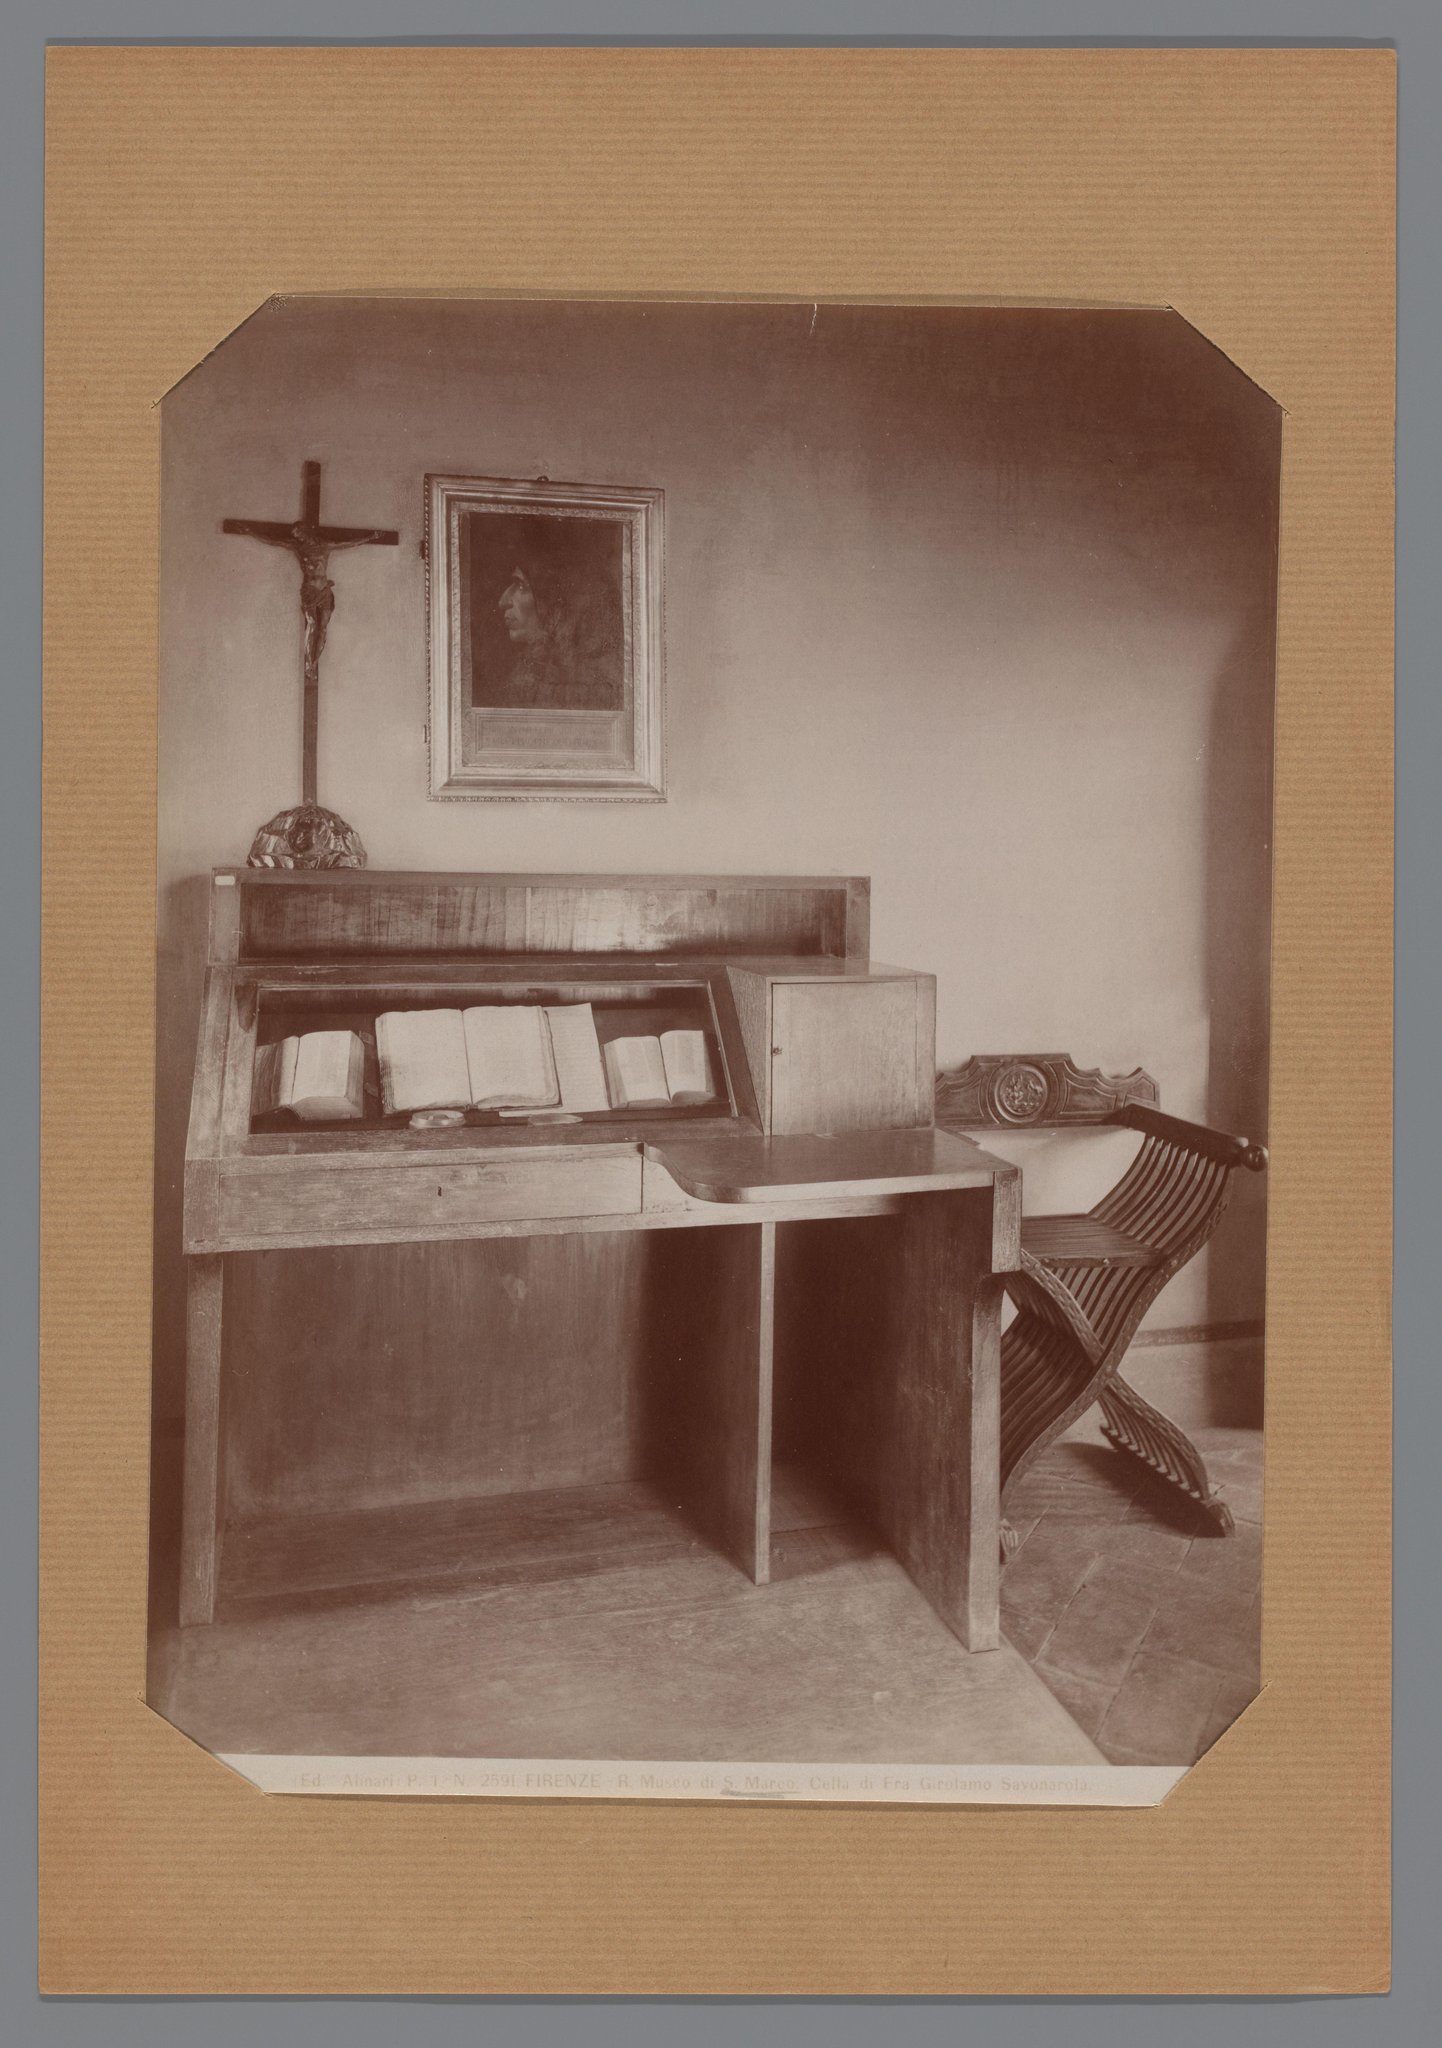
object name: photograph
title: Italië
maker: Anonymous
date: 1880-1910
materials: photographic support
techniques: albumen print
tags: italy